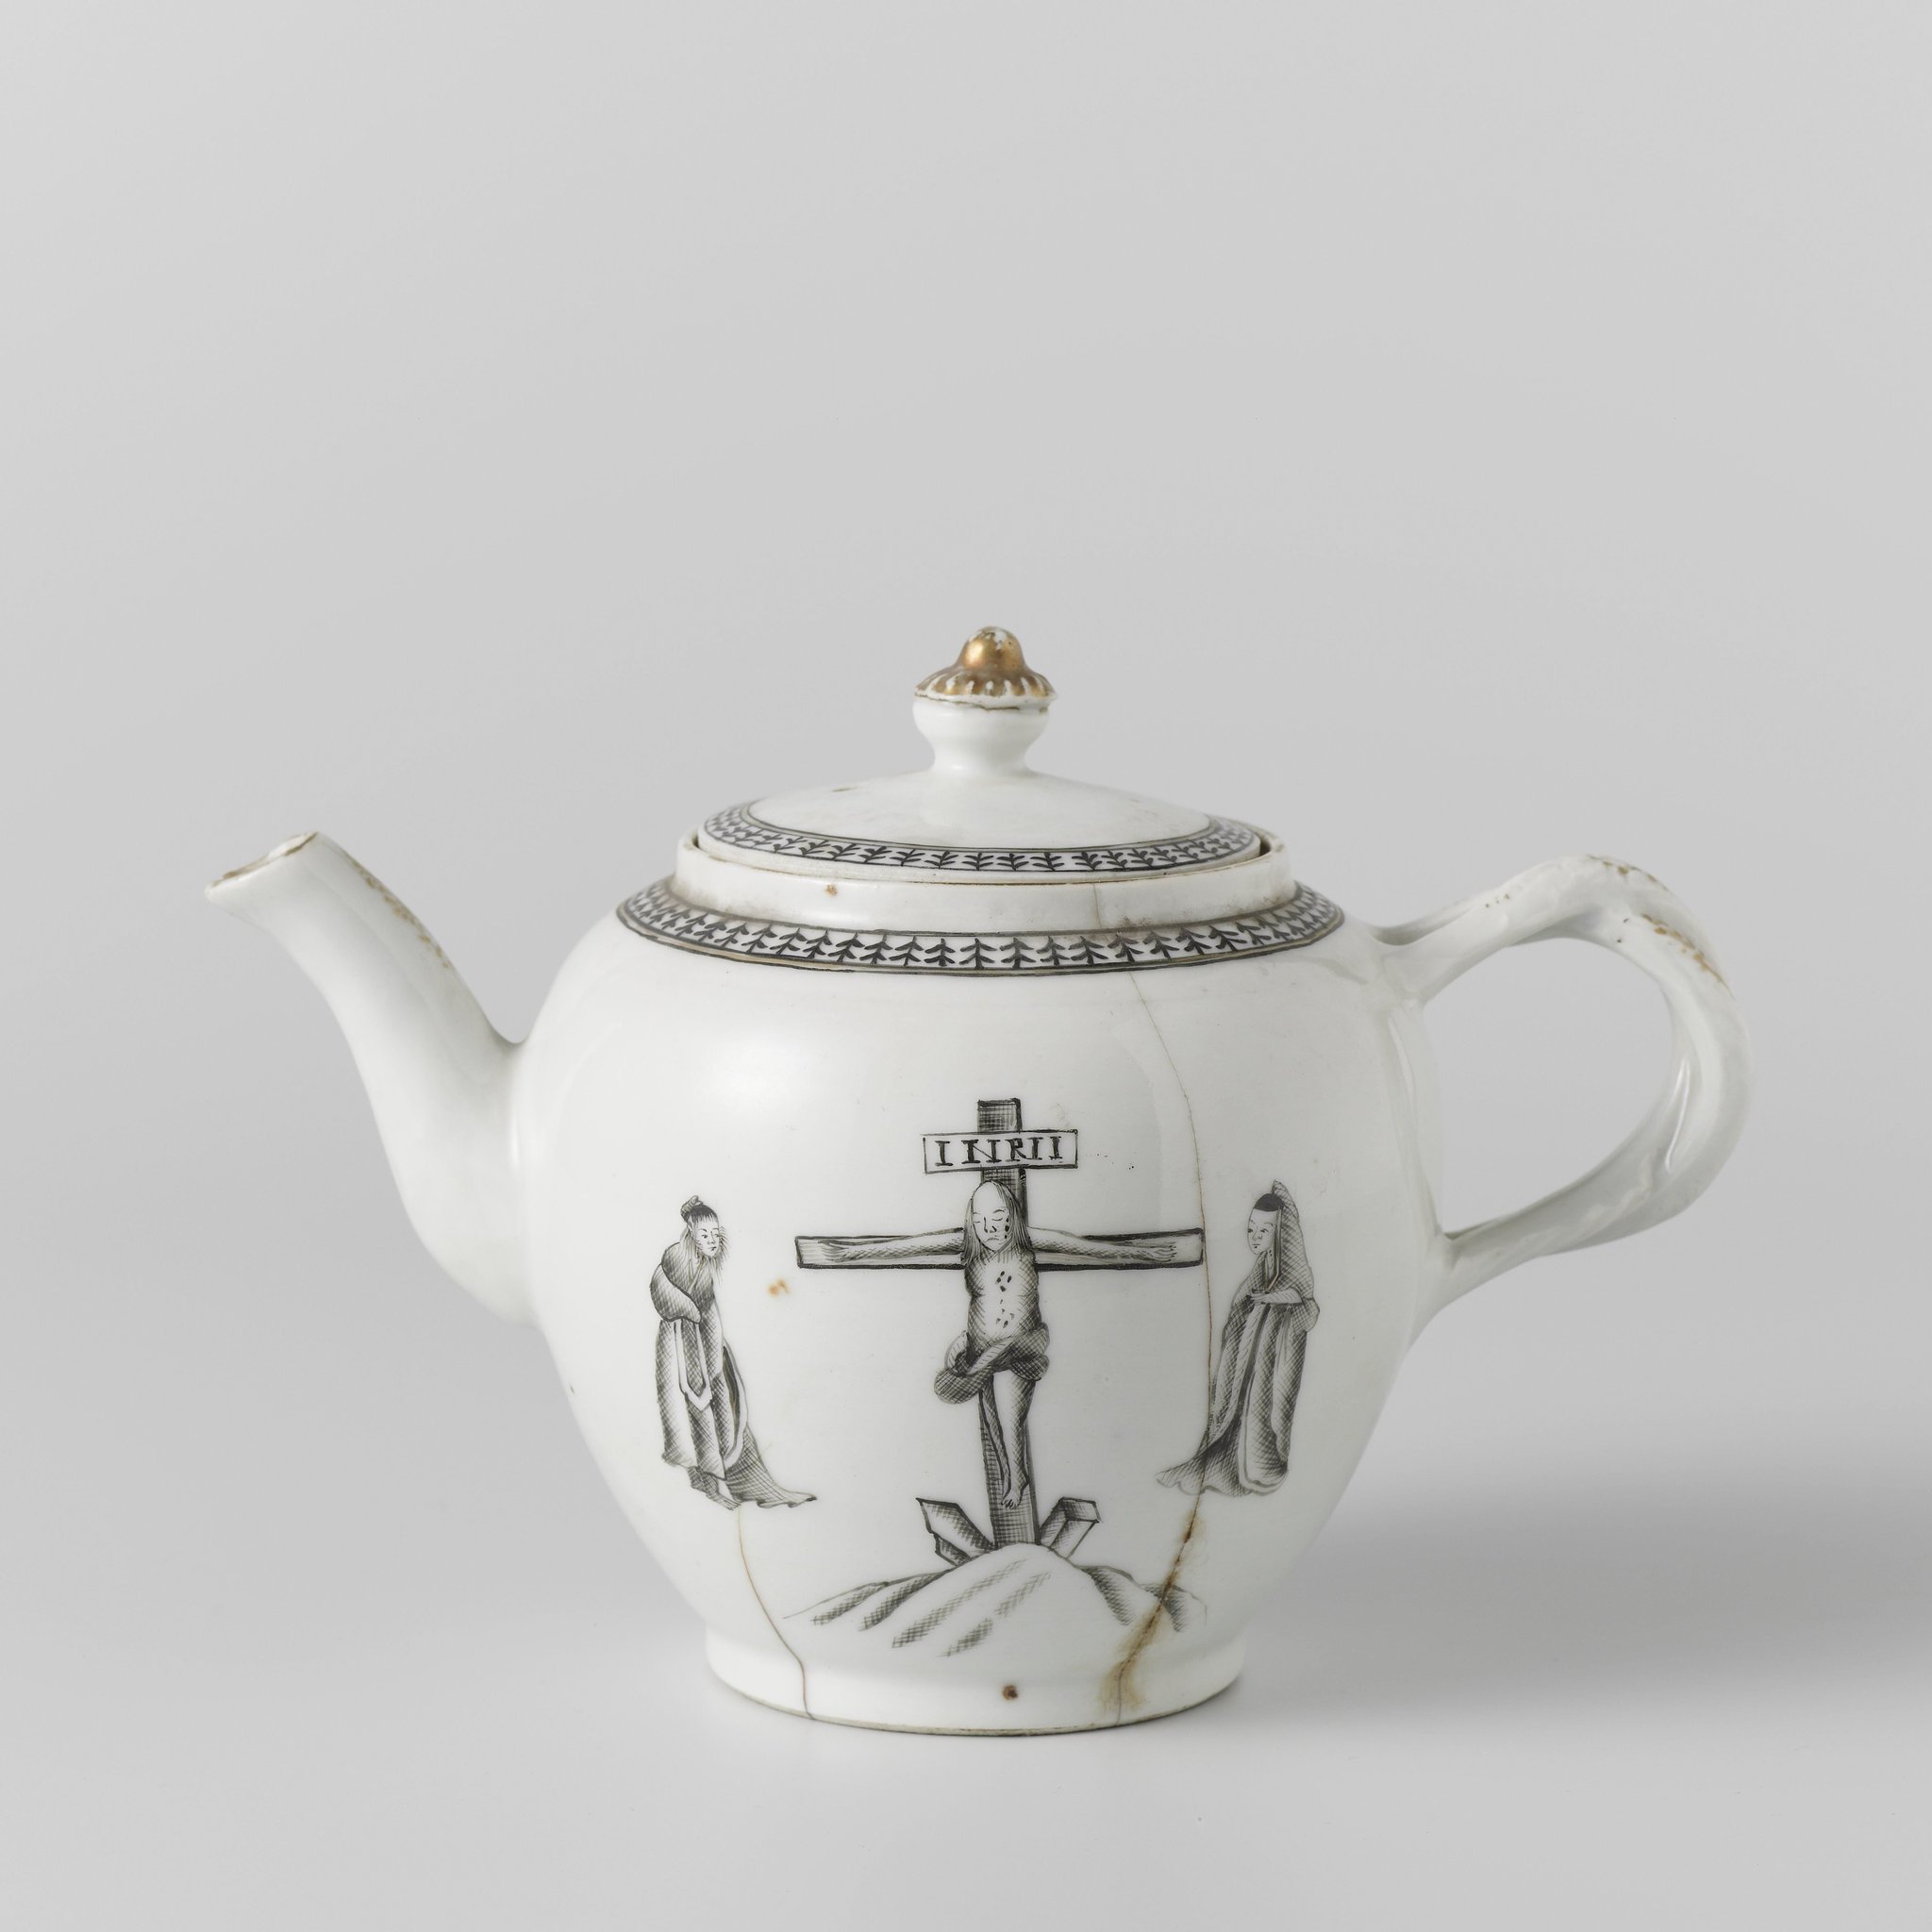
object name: teapot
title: Ovoid teapot with a crucifixion scene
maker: Anonymous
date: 1780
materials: glaze, gold, paint, porcelain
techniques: firing, forming, gilding, turning, vitrification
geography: china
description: Eivormige theepot van porselein met ingegrift, gevlochten c-vormig oor, gebogen tuit en deksel, beschilderd op het glazuur in zwart en goud. Op de buitenzijde een voorstelling van de Kruisiging met de twee Maria's; de schouder en de dekselrand met een band met een decoratief patroon. Pot is gebroken geweest. Onderdeel van een theeservies. Europese voorstelling in encre de Chine.